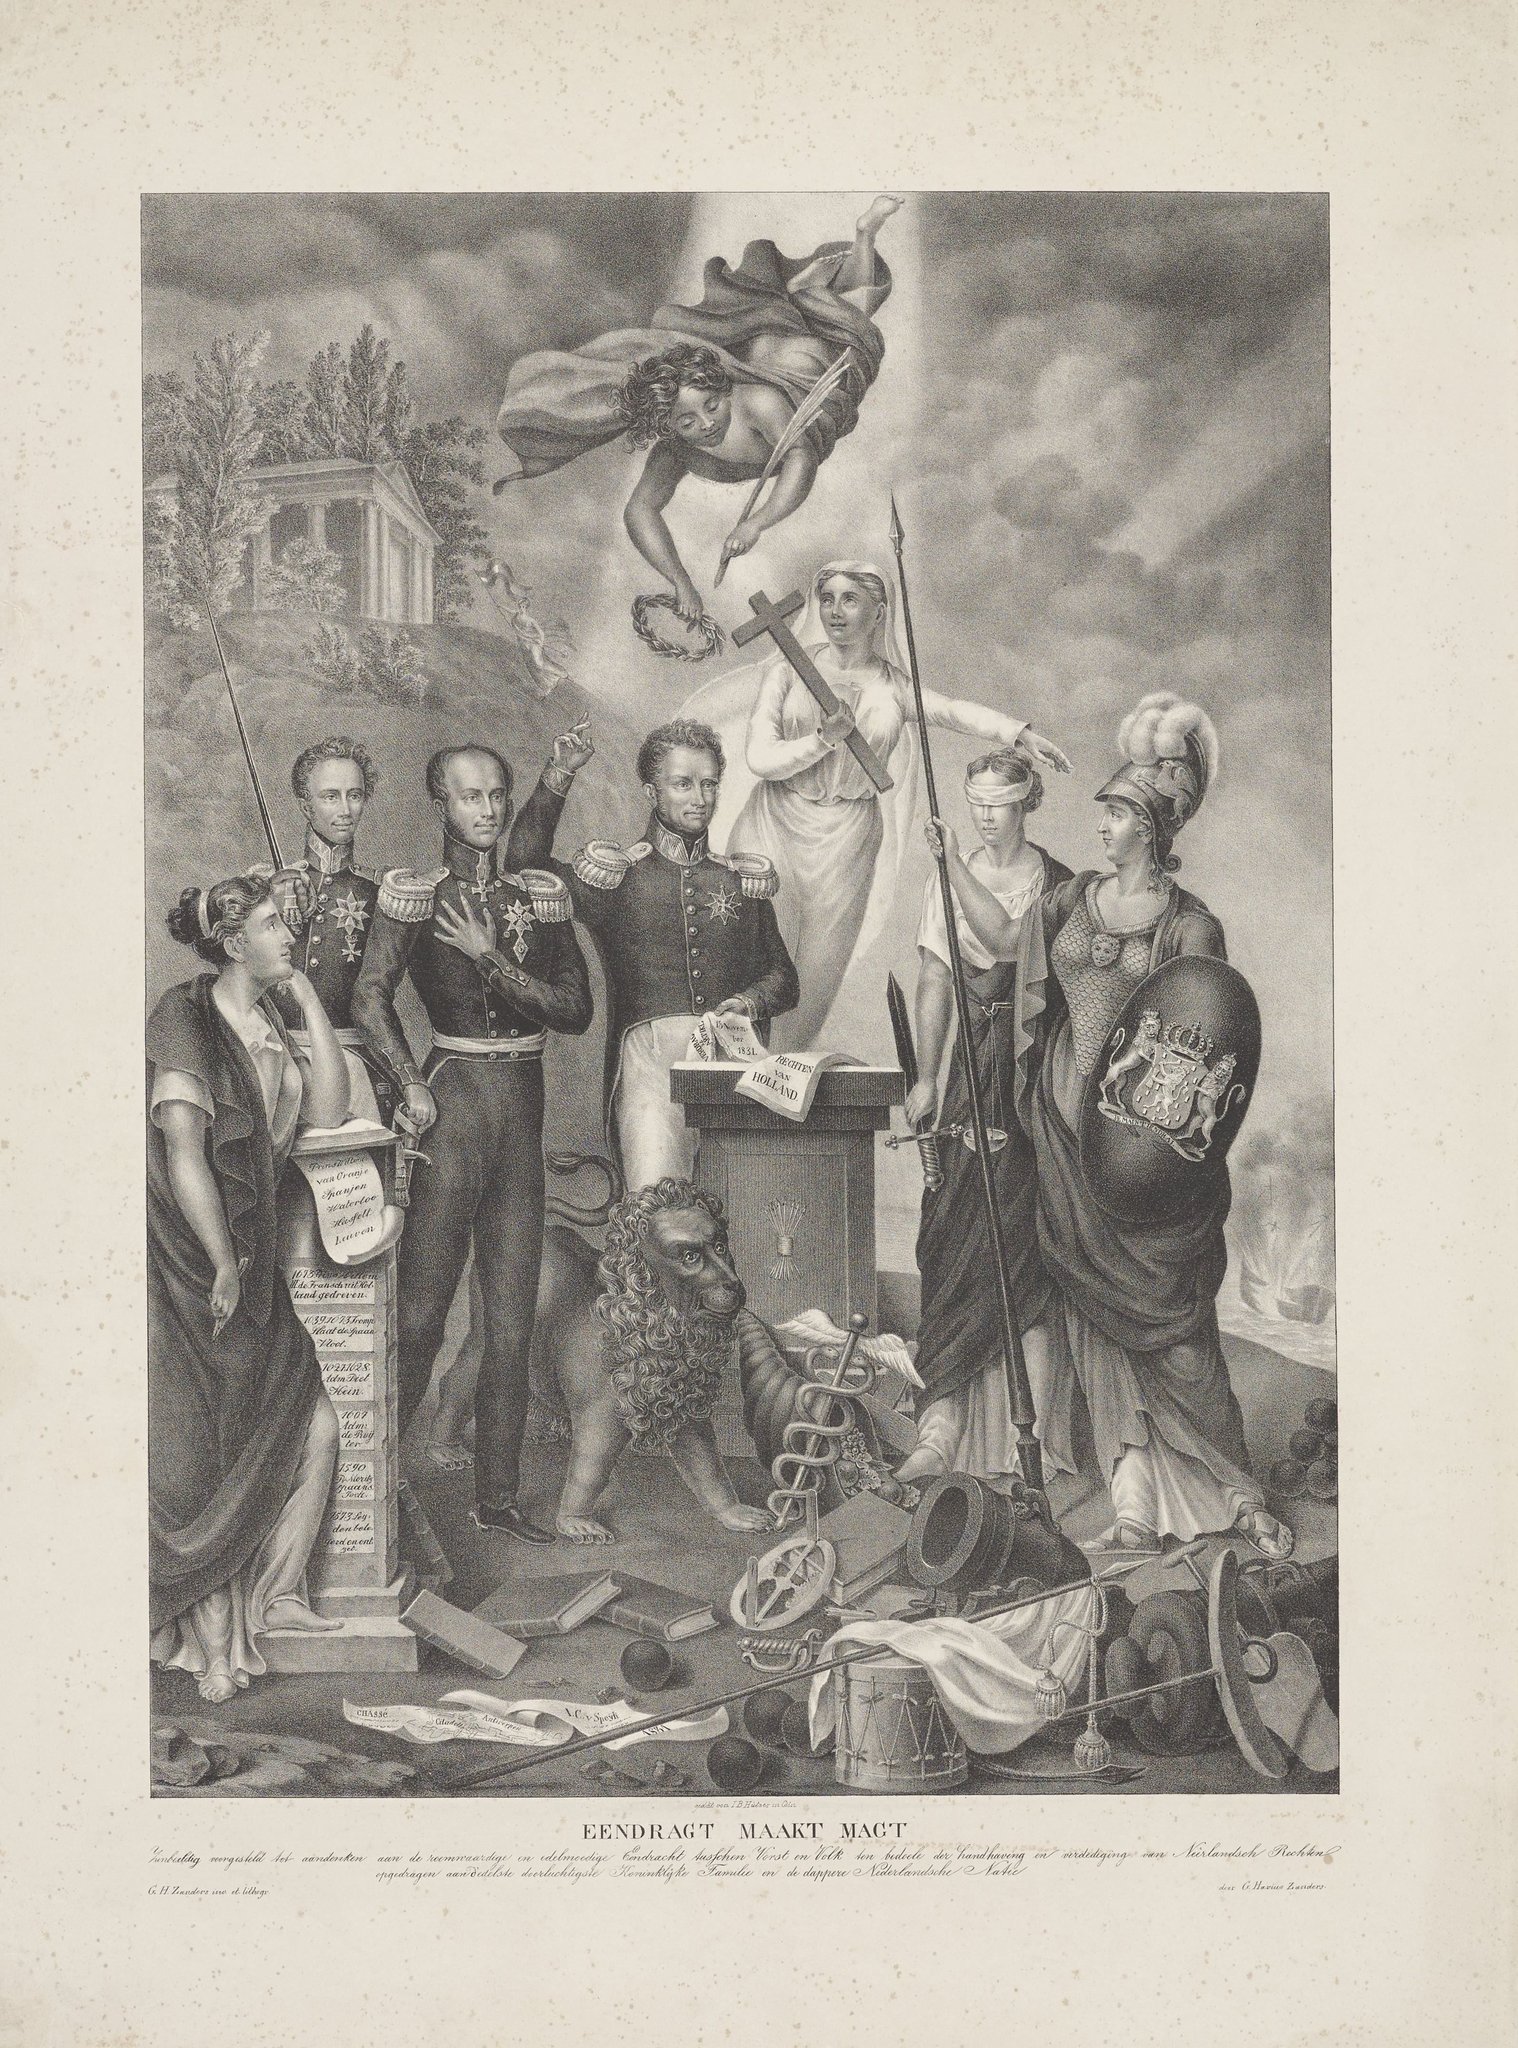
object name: print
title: Allegorie op het verbond tussen vorst en volk, 1832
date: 1832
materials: paper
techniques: lithograph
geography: cologne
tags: amsterdam, antwerp, jan van speyk, david hendrik baron chassé, the hague, berlin, william i of the netherlands, william ii of the netherlands, frederik (prins der nederlanden), justice, 'justitia'; 'giustitia divina' (ripa) ~ one of the four cardinal virtues, personifications of countries, nations, states, districts, etc., allegorical representations ~ religion; 'religione', 'religione de ss. mauritio e lazaro', 'religione vera christiana' (ripa), 'historia'; 'historia' (ripa), swearing an oath (with two fingers raised)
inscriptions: collector's mark: Lugt 2228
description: Allegorie op het verbond tussen vorst en volk, 1832. Links van een altaar staan koning Willem I en zijn twee zoons. Rechts de Rechtvaardigheid en de Nederlandse Maagd. Links de Geschiedenis leunend op een zuil waarop de roemrijke gebeurtenissen uit de Nederlandse geschiedenis. In de lucht de Godsdienst en een engel met palmtak en lauwerkrans bestemd voor de koning. Op de achtergrond een tempel op een heuvel en het ontploffen van het schip van Jan van Speyk. De koning legt een eed af en verscheurt het Verdrag der 24 Artikelen met de datum 15 november 1831. Op de grond symbolen van de oorlog, kunsten, handel en wetenschap. Twee documenten verwijzen naar de dood van Van Speijk en de verdediging van de Citadel van Antwerpen door Chassé.